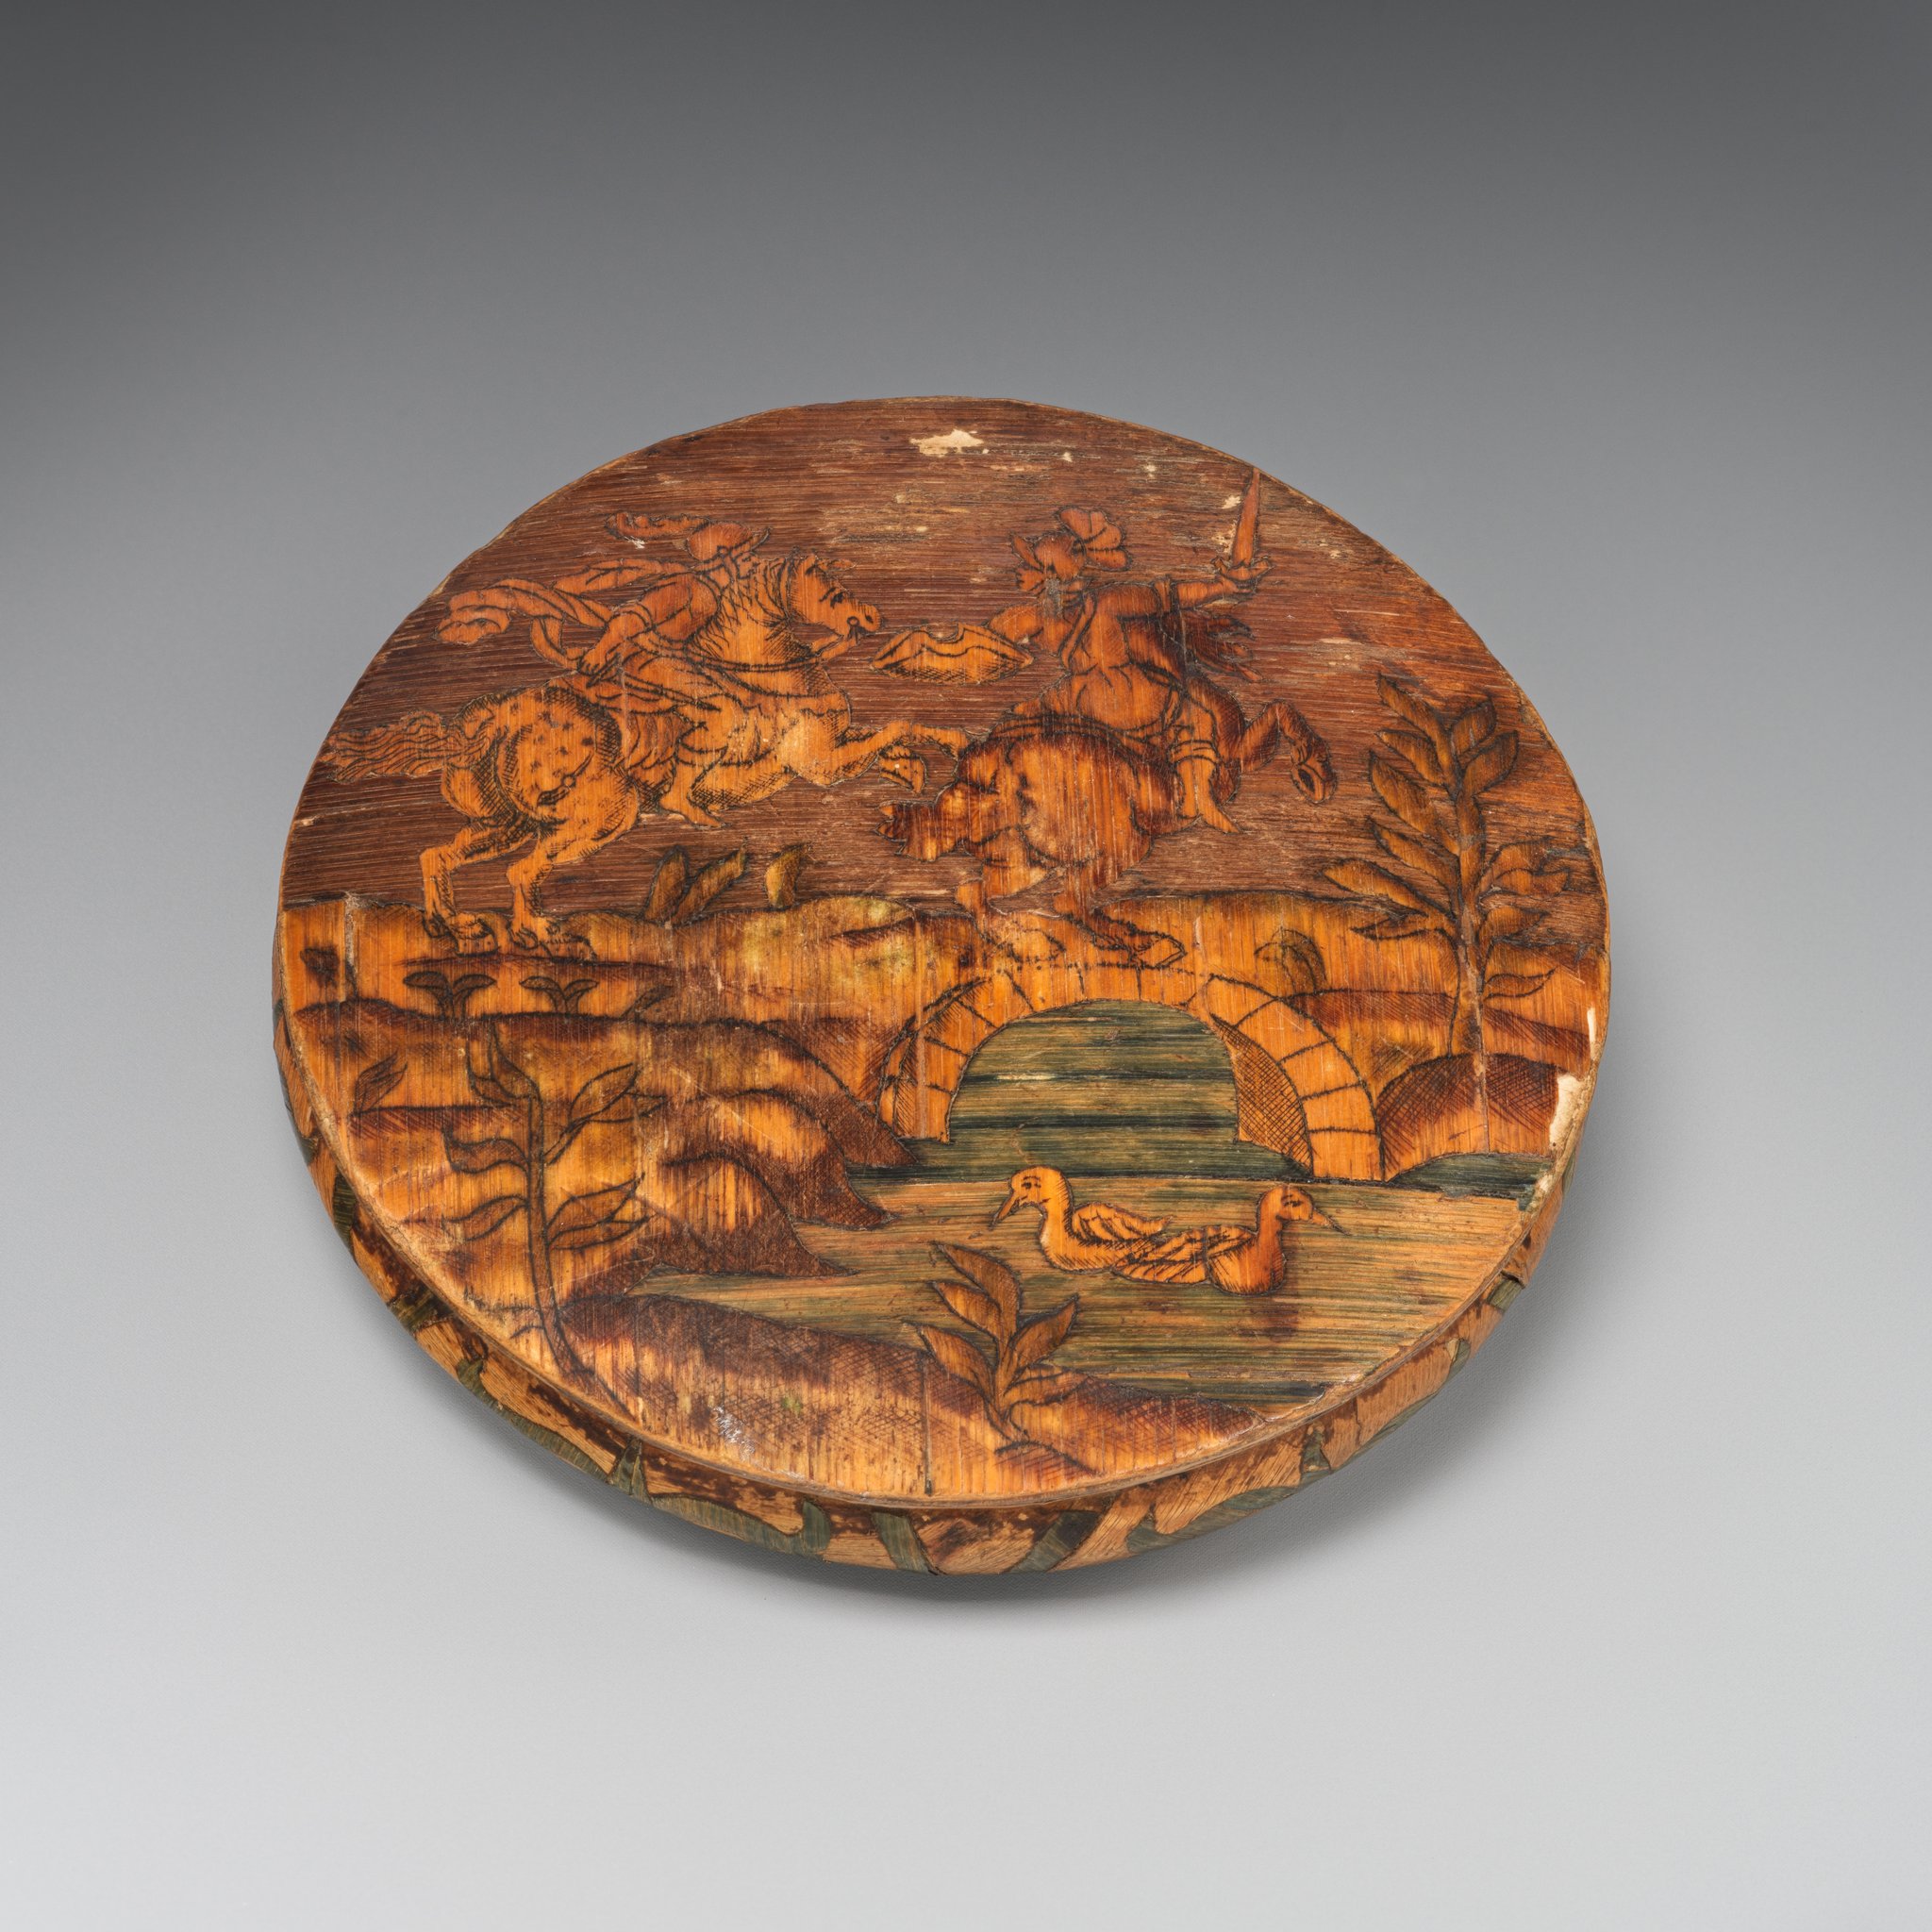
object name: box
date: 1767-1800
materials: paint, paper, fiber